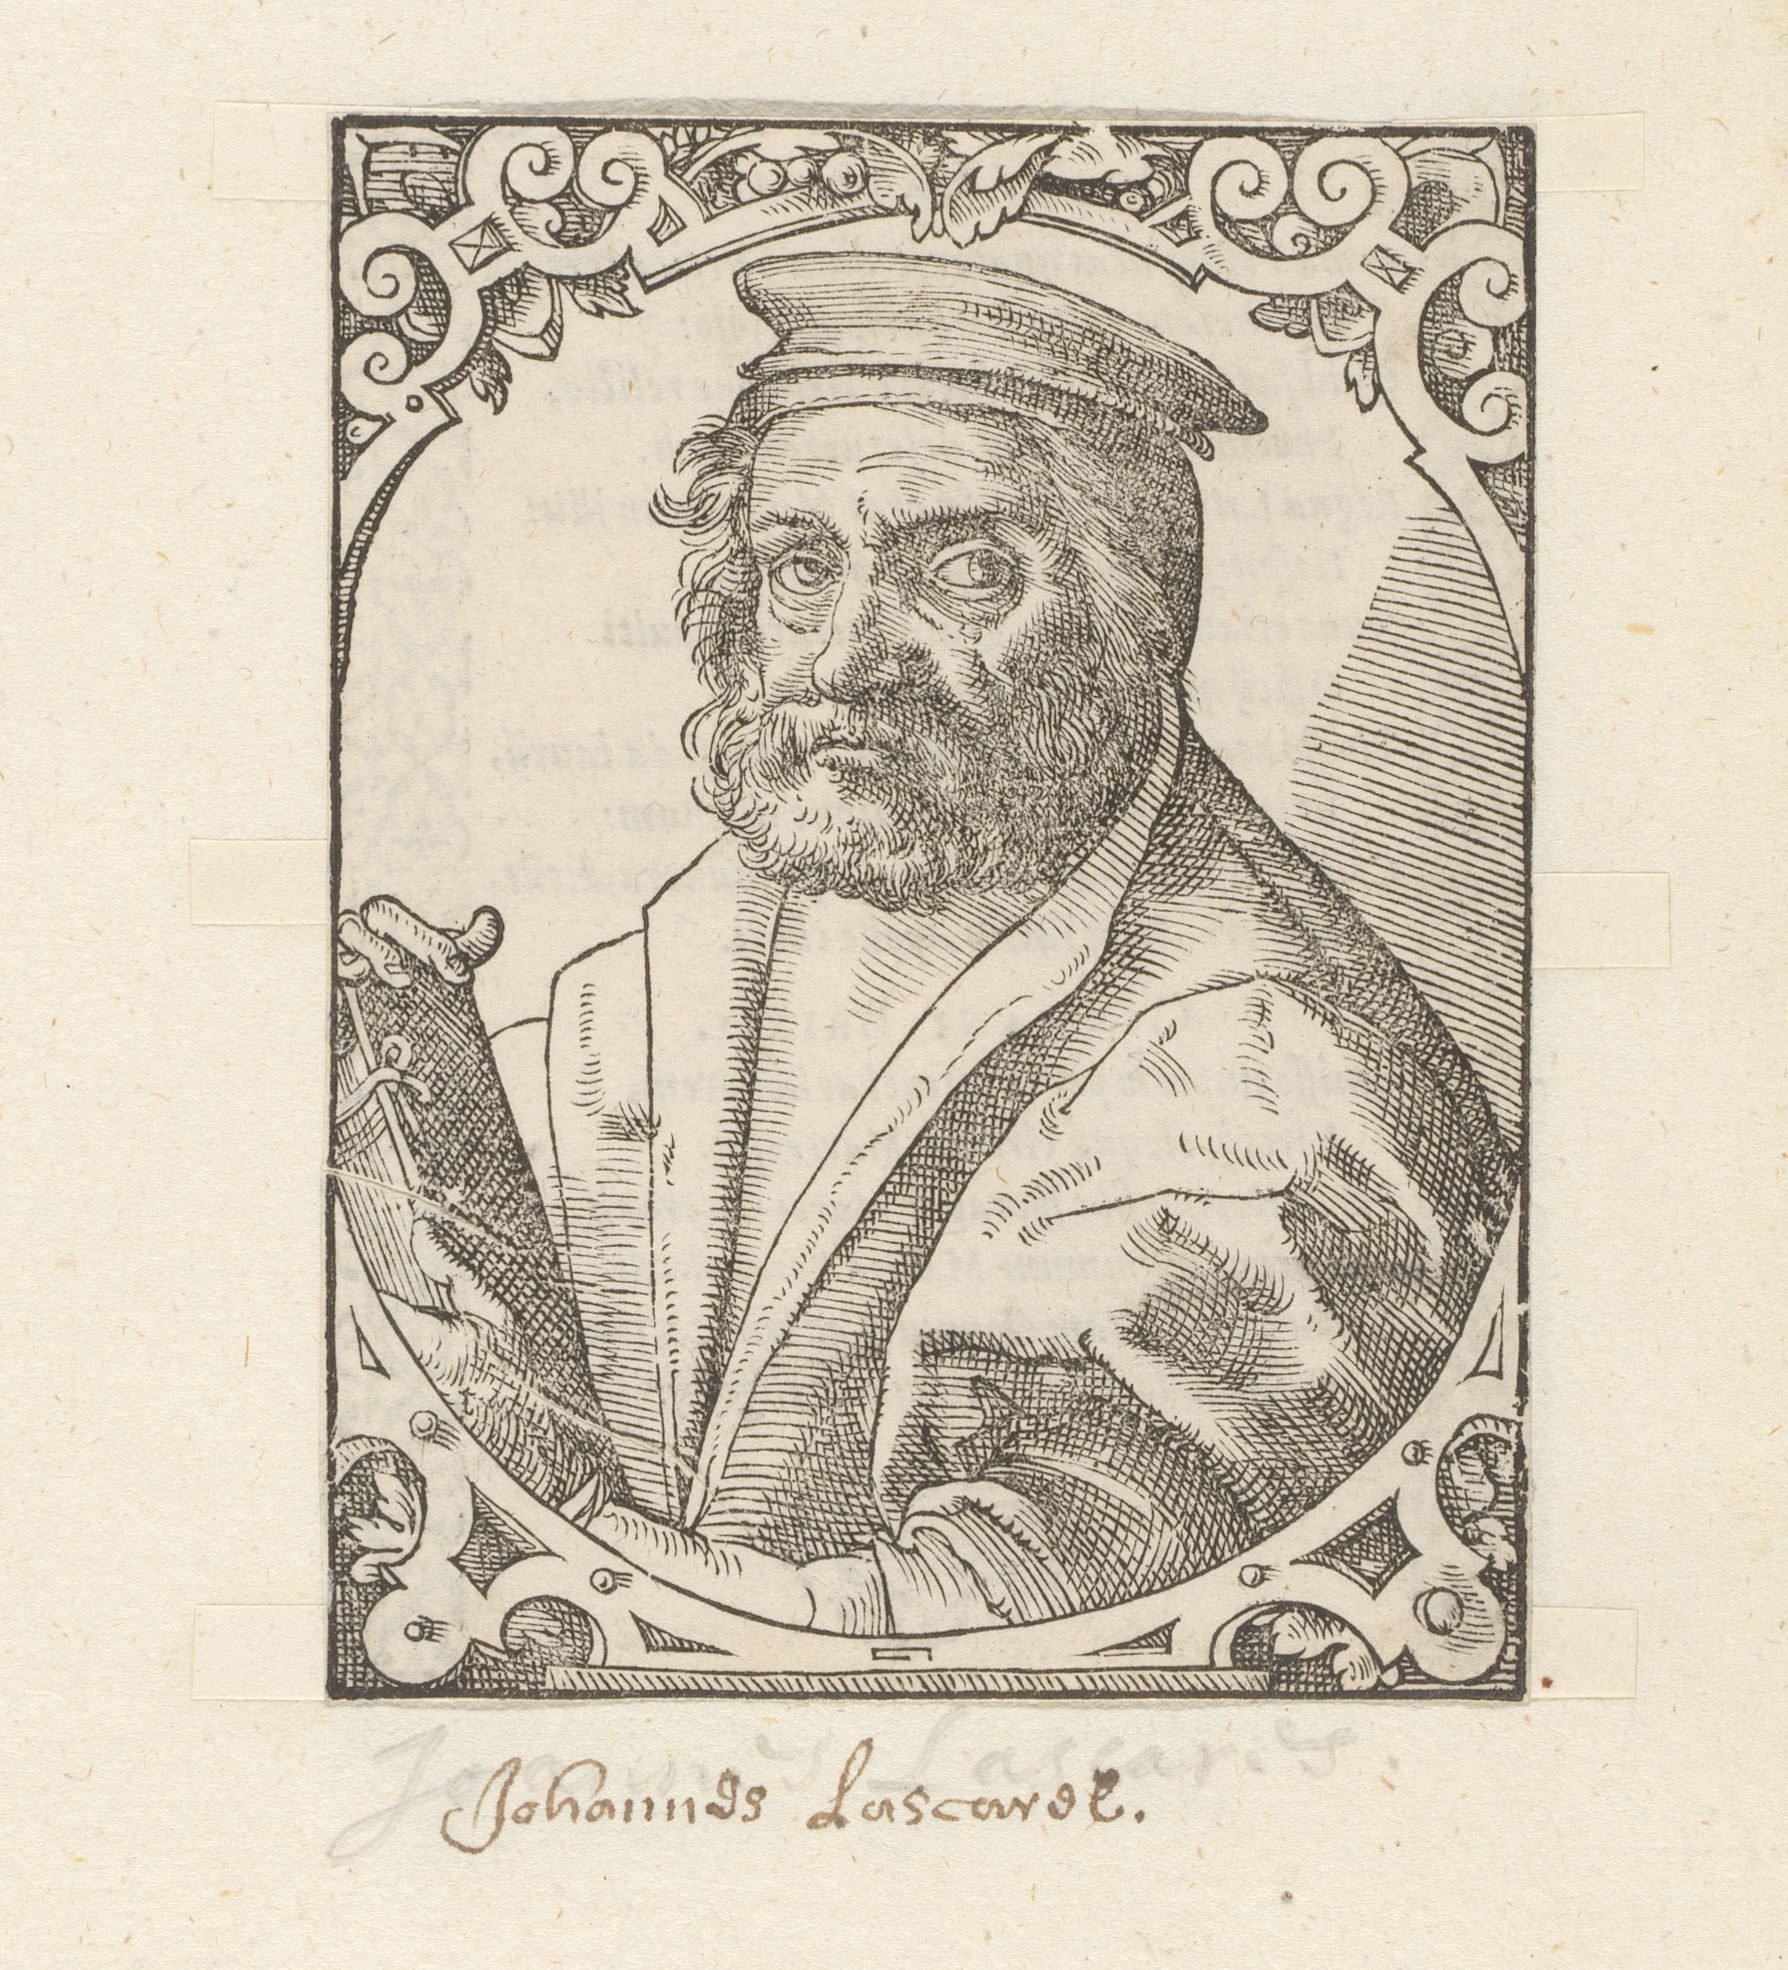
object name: album leaf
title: Portret van Johannes Lascaris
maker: Anonymous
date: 1549-1577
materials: paper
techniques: letterpress printing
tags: rome, historical persons, portrait of a writer, diplomacy, diplomat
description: Prent gebruikt in: Giovio, Paolo. Elogia Virorum literis illustrium (...). Bazel: Peter Perna, 1577.